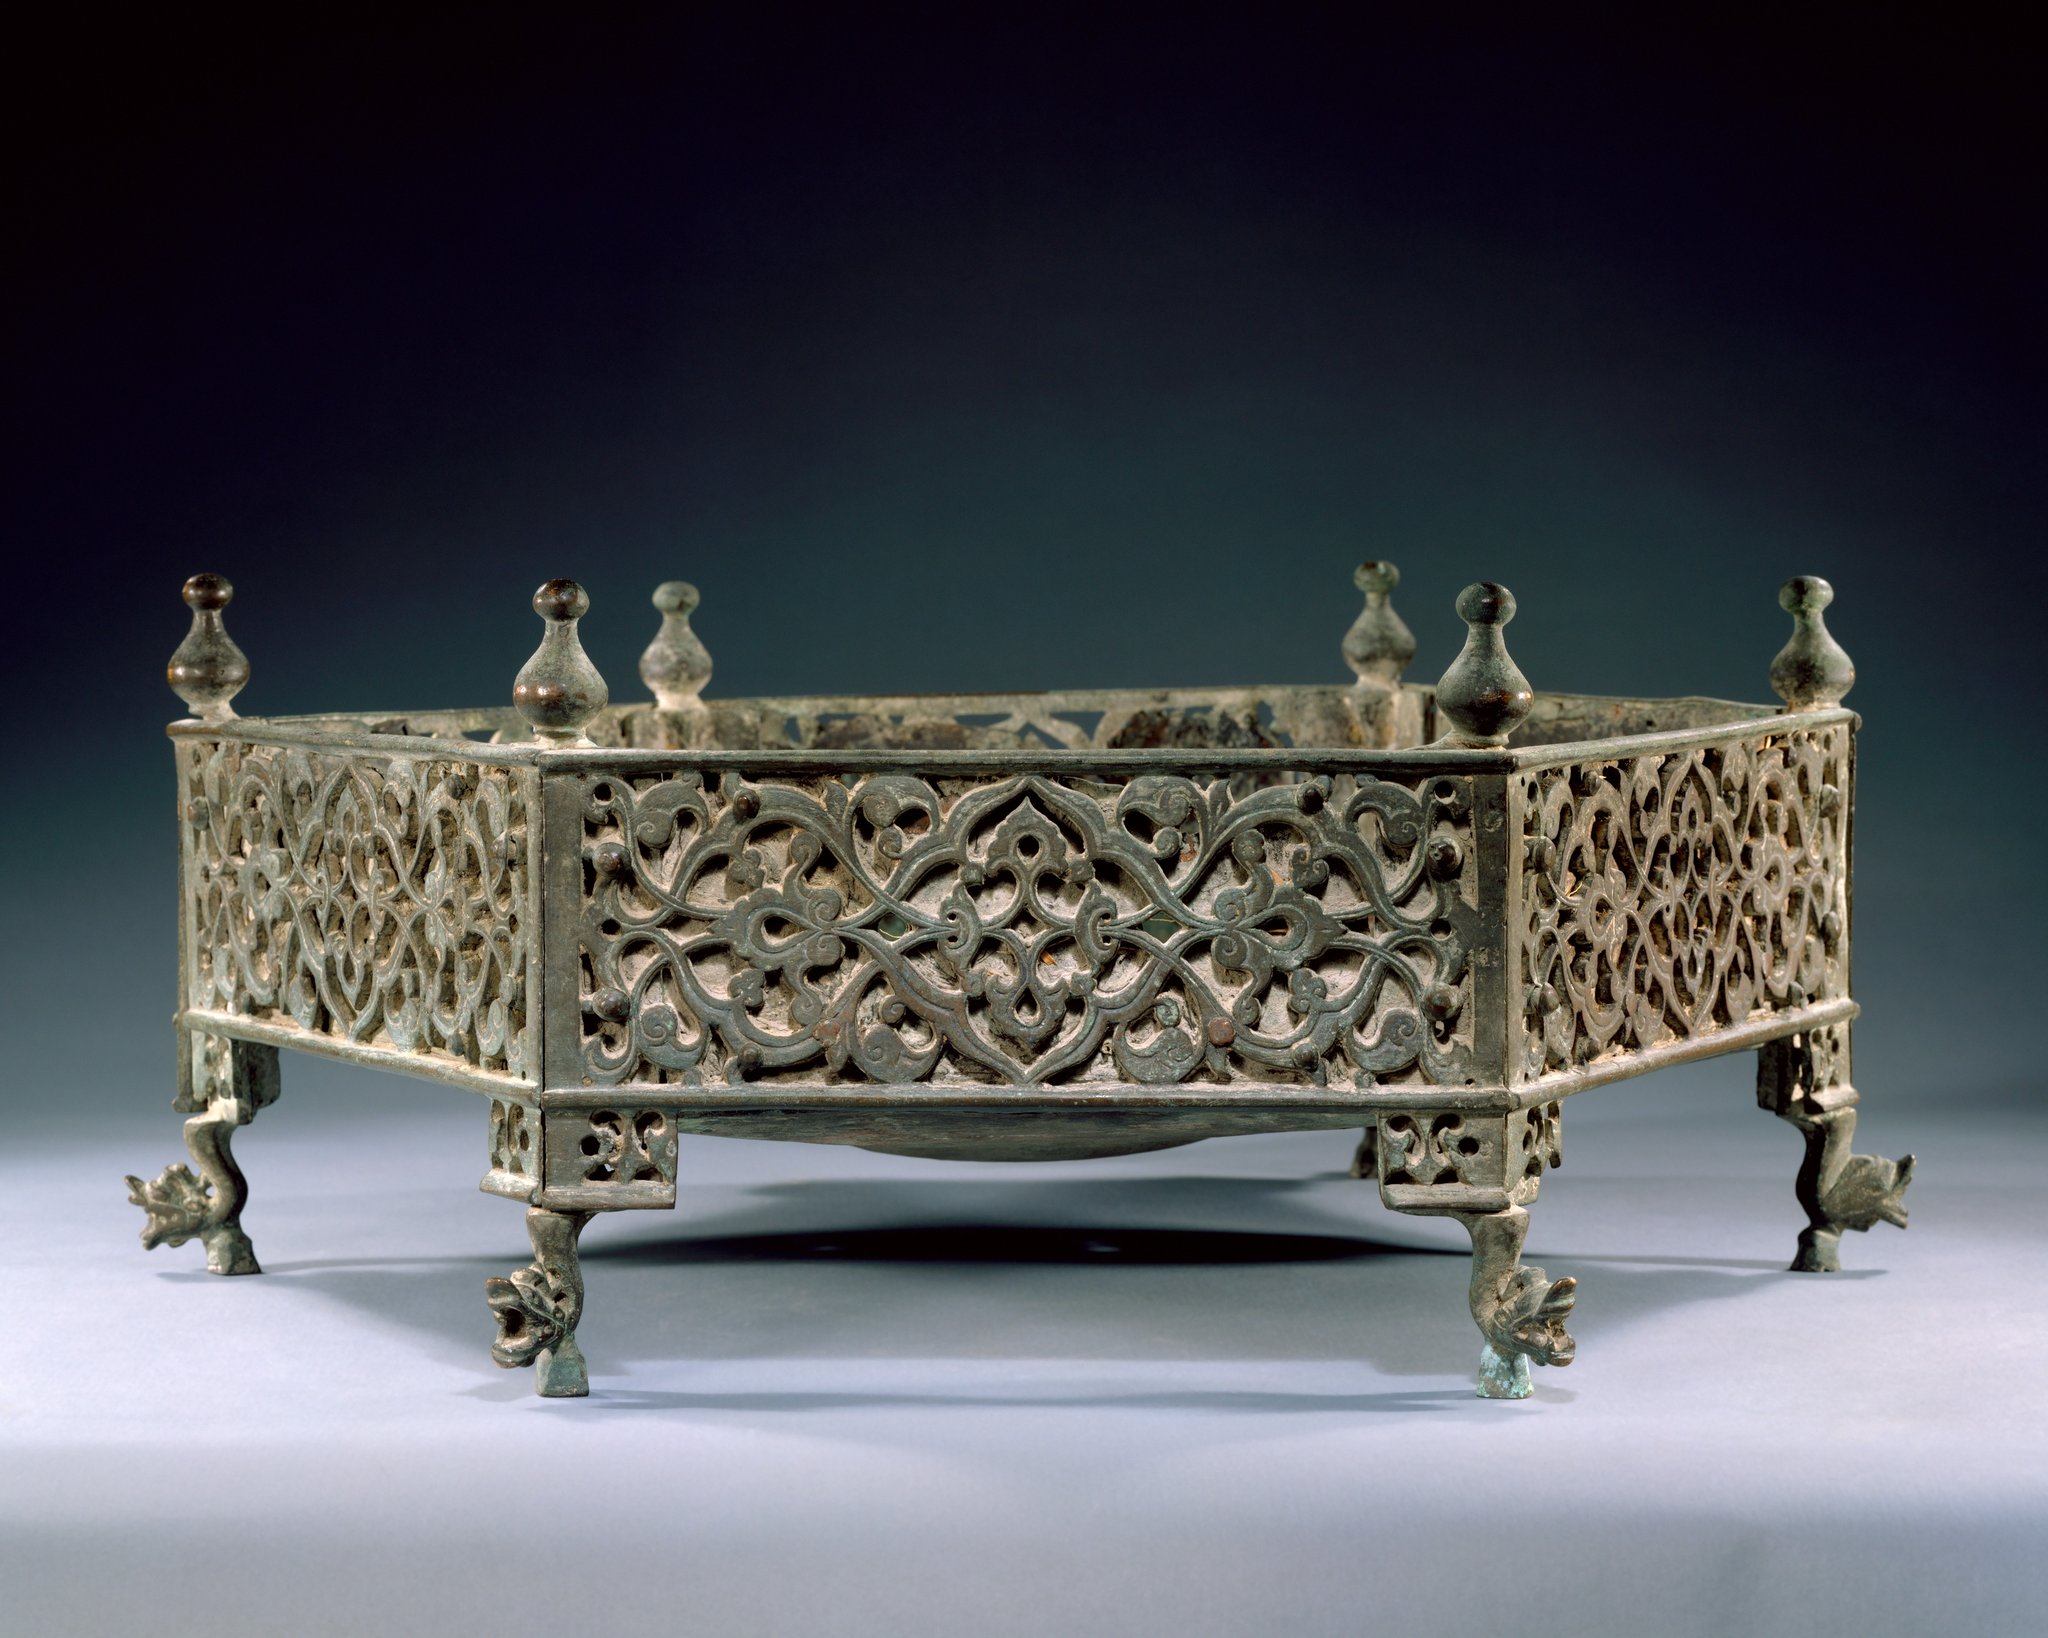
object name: brazier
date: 1401-1500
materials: bronze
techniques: casting, chasing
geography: india